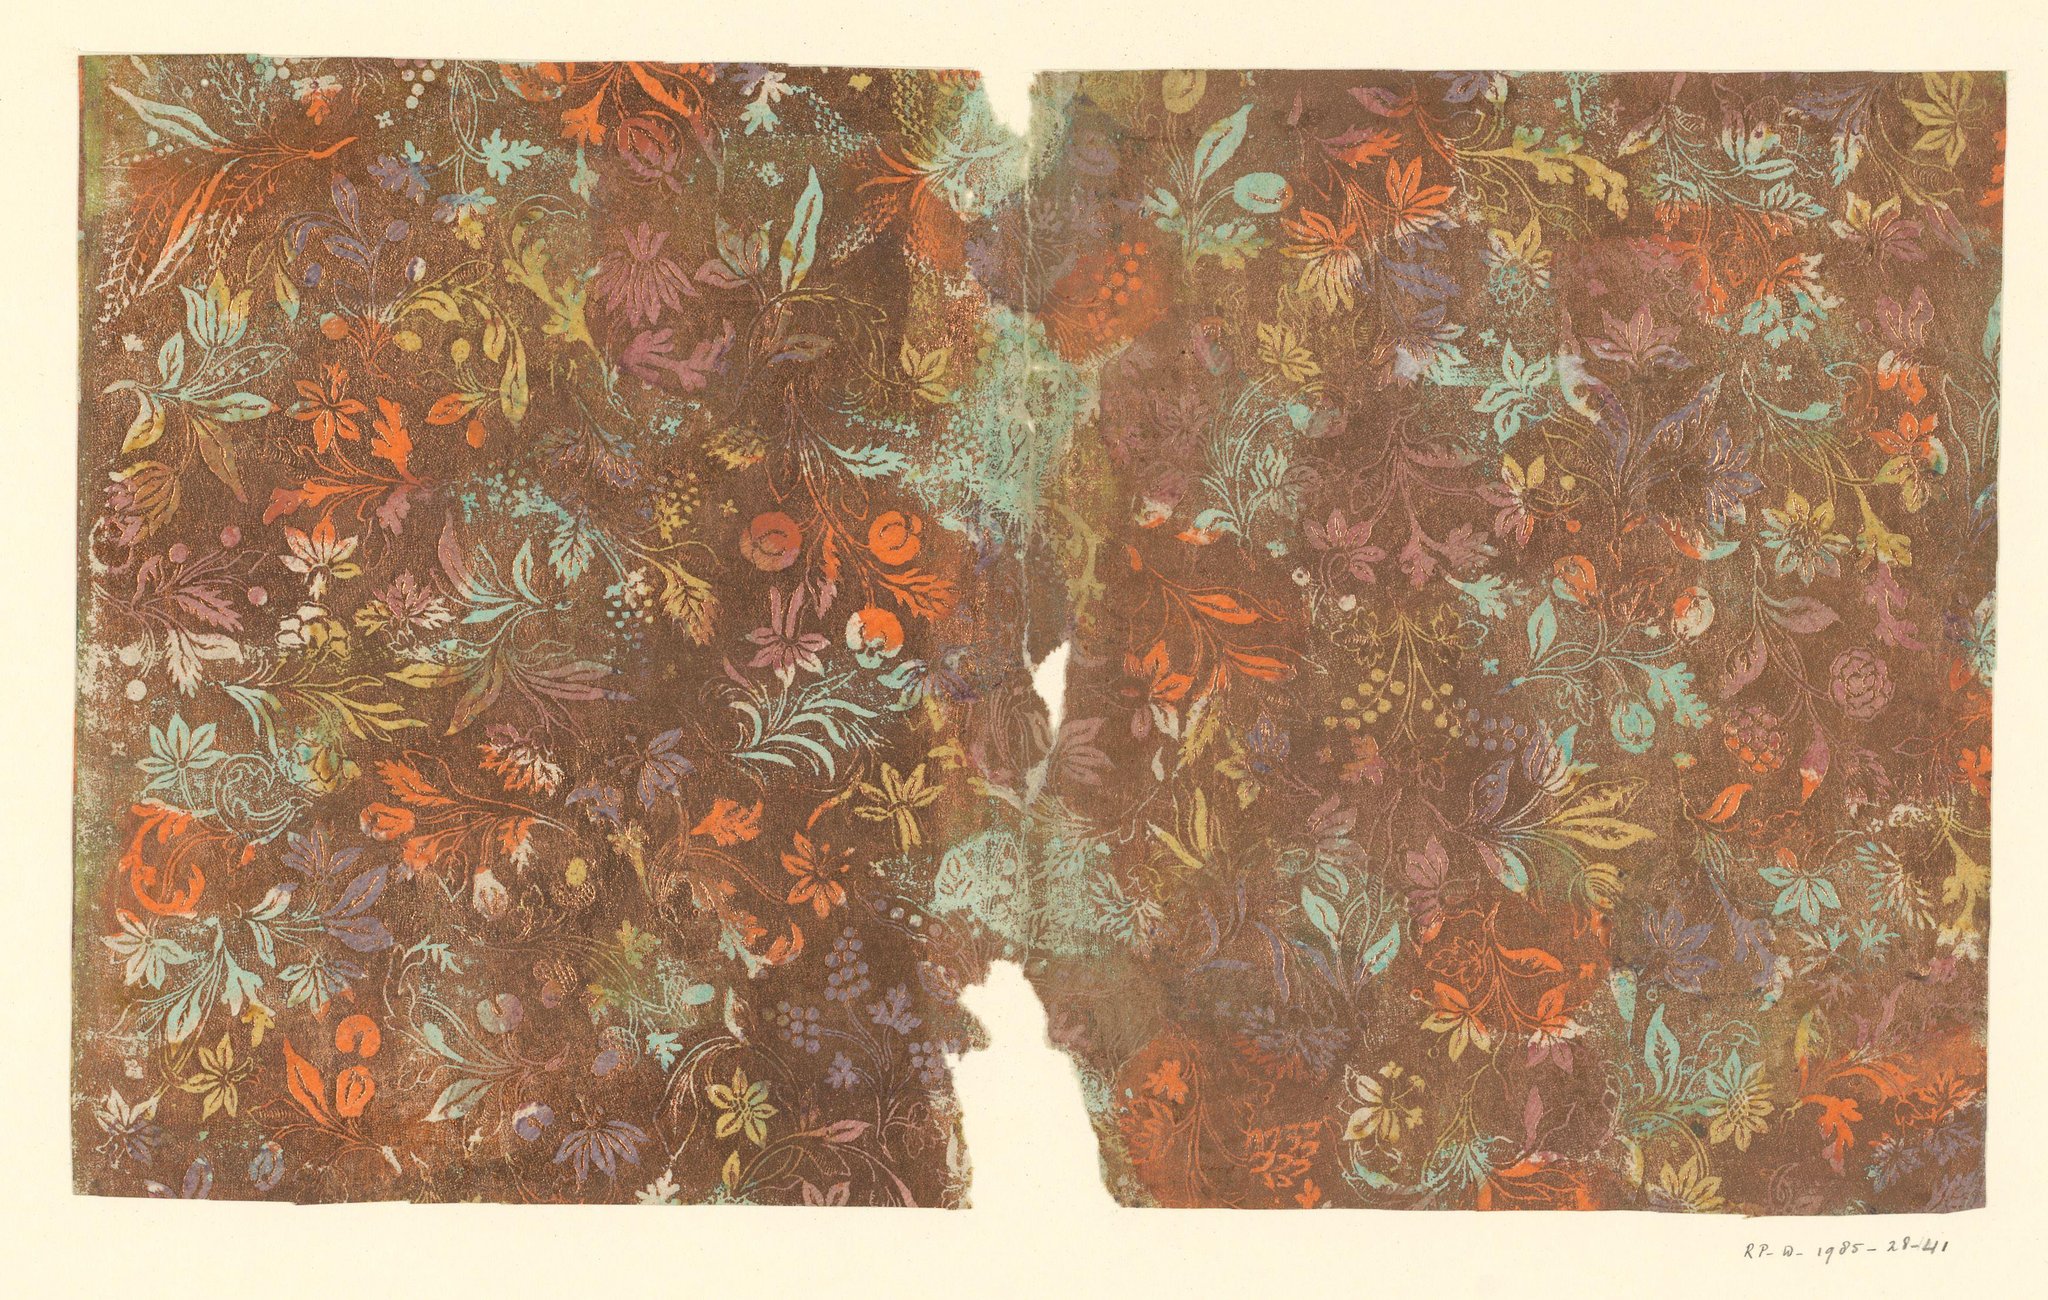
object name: brocade paper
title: Blad met bloemen en vruchten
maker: Anonymous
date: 1700-1850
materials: gold leaf, paint, paper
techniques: relief print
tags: ornament derived from plant forms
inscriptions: collector's mark: Lugt 2760, collector's mark: Lugt 2228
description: Blad met bloemen en vruchten. In het midden doorgesleten met papierverlies. Gebruikt als omslag.